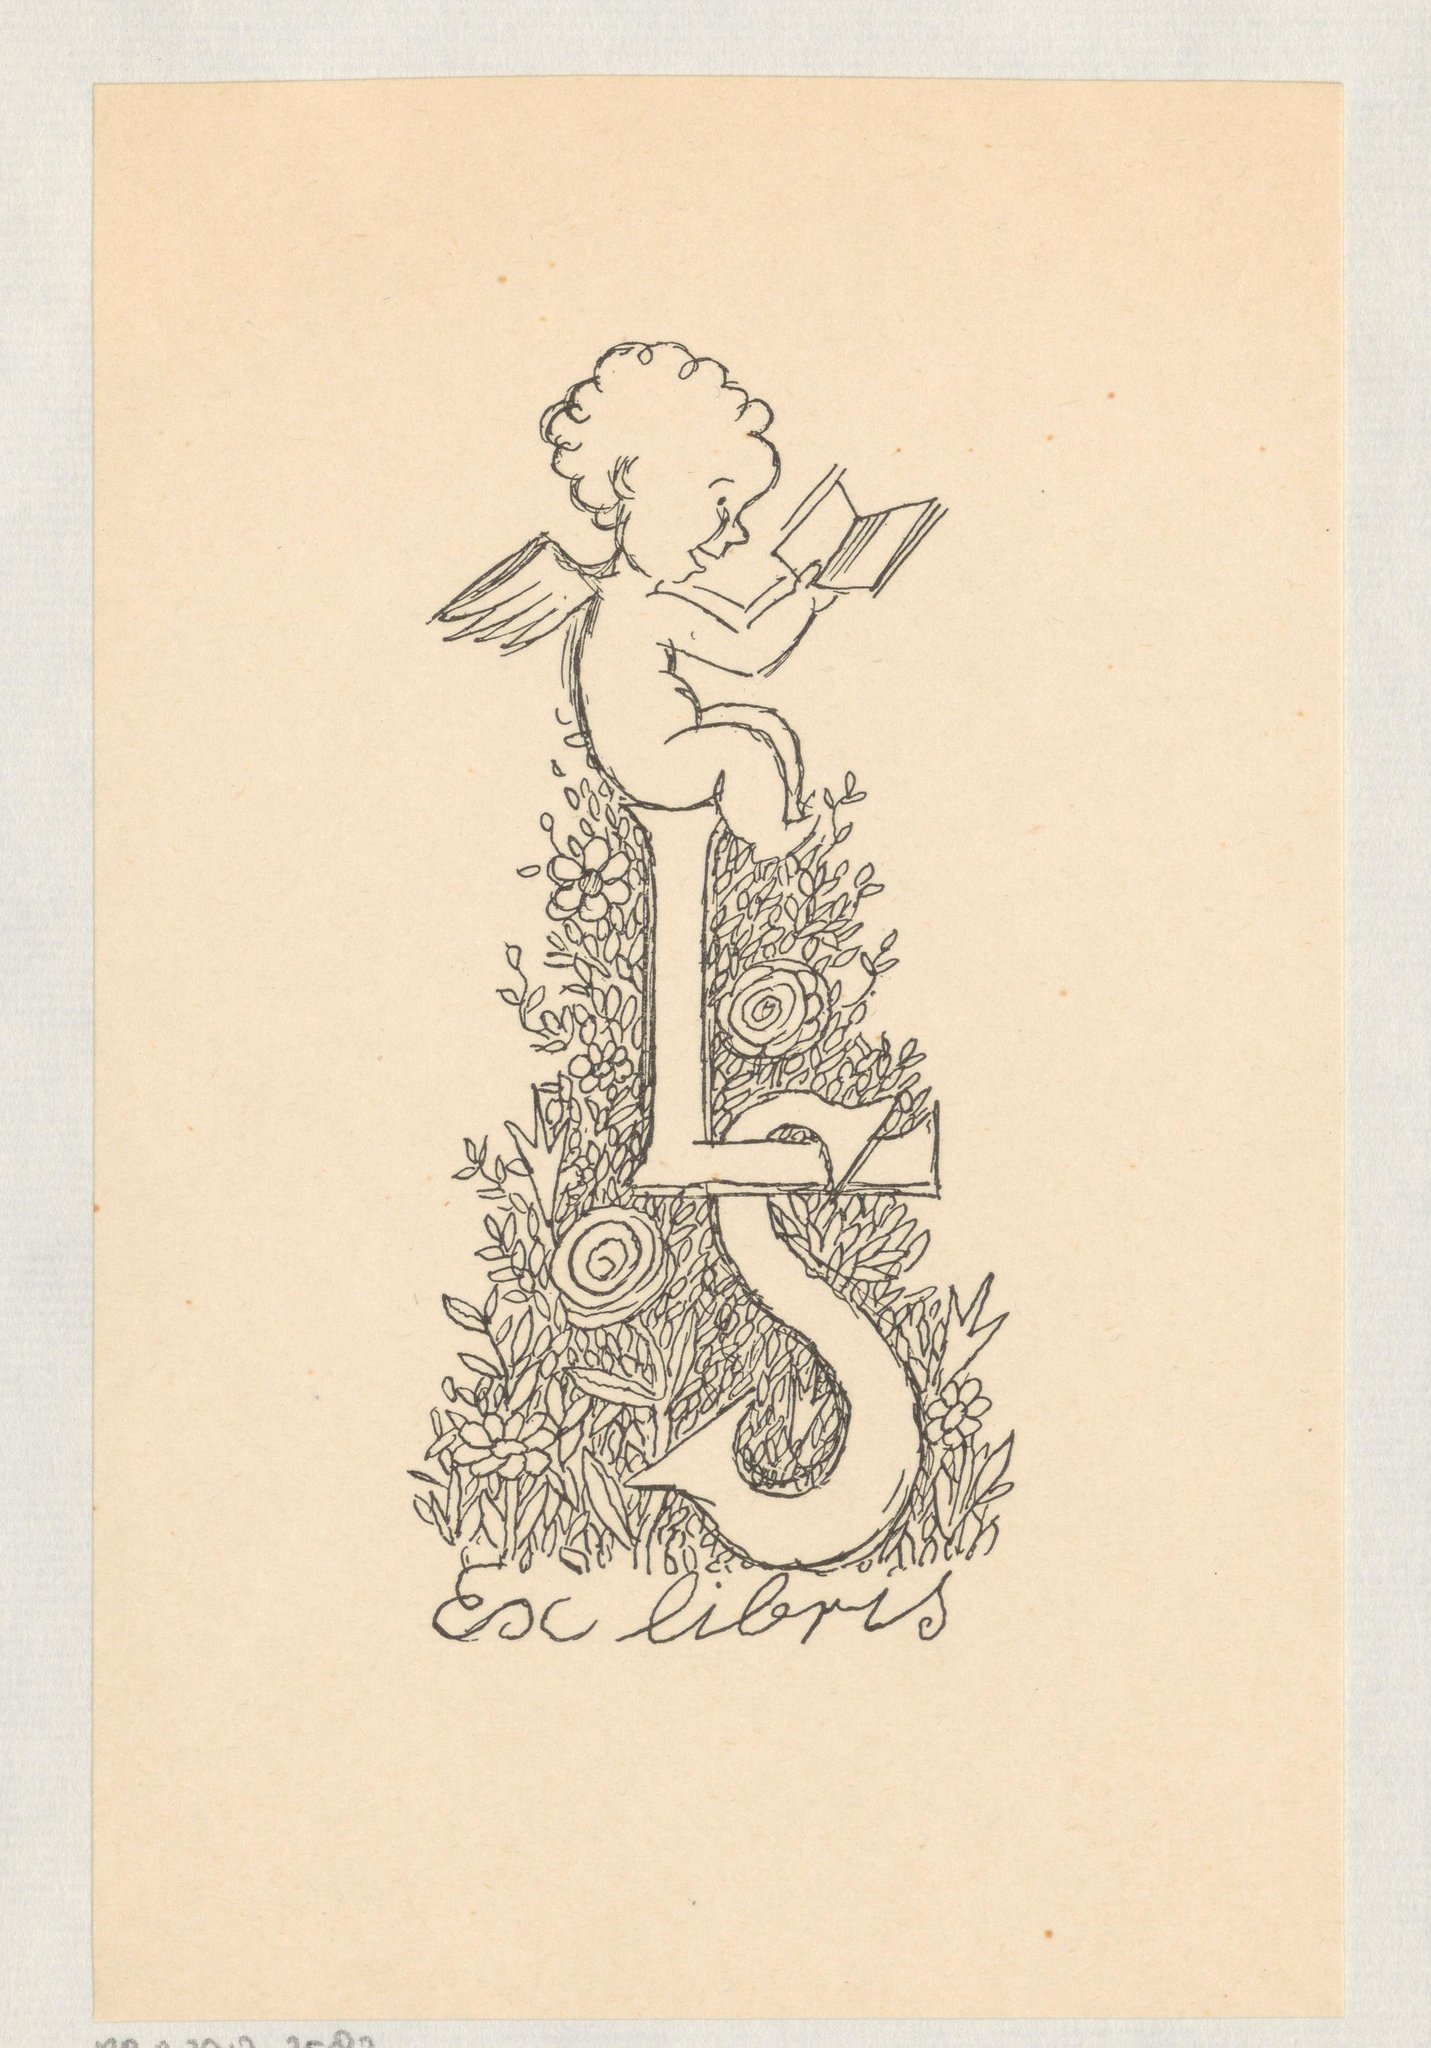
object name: bookplate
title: Ex libris van L.S.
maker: michel fingesten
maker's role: painter, print maker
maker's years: 1884-1943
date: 1894-1943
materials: paper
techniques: lithograph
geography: milan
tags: flowers, reading, cupids: 'amores', 'amoretti', 'putti'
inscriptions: workshop stamp: ‘Michel Fingesten / Milano’